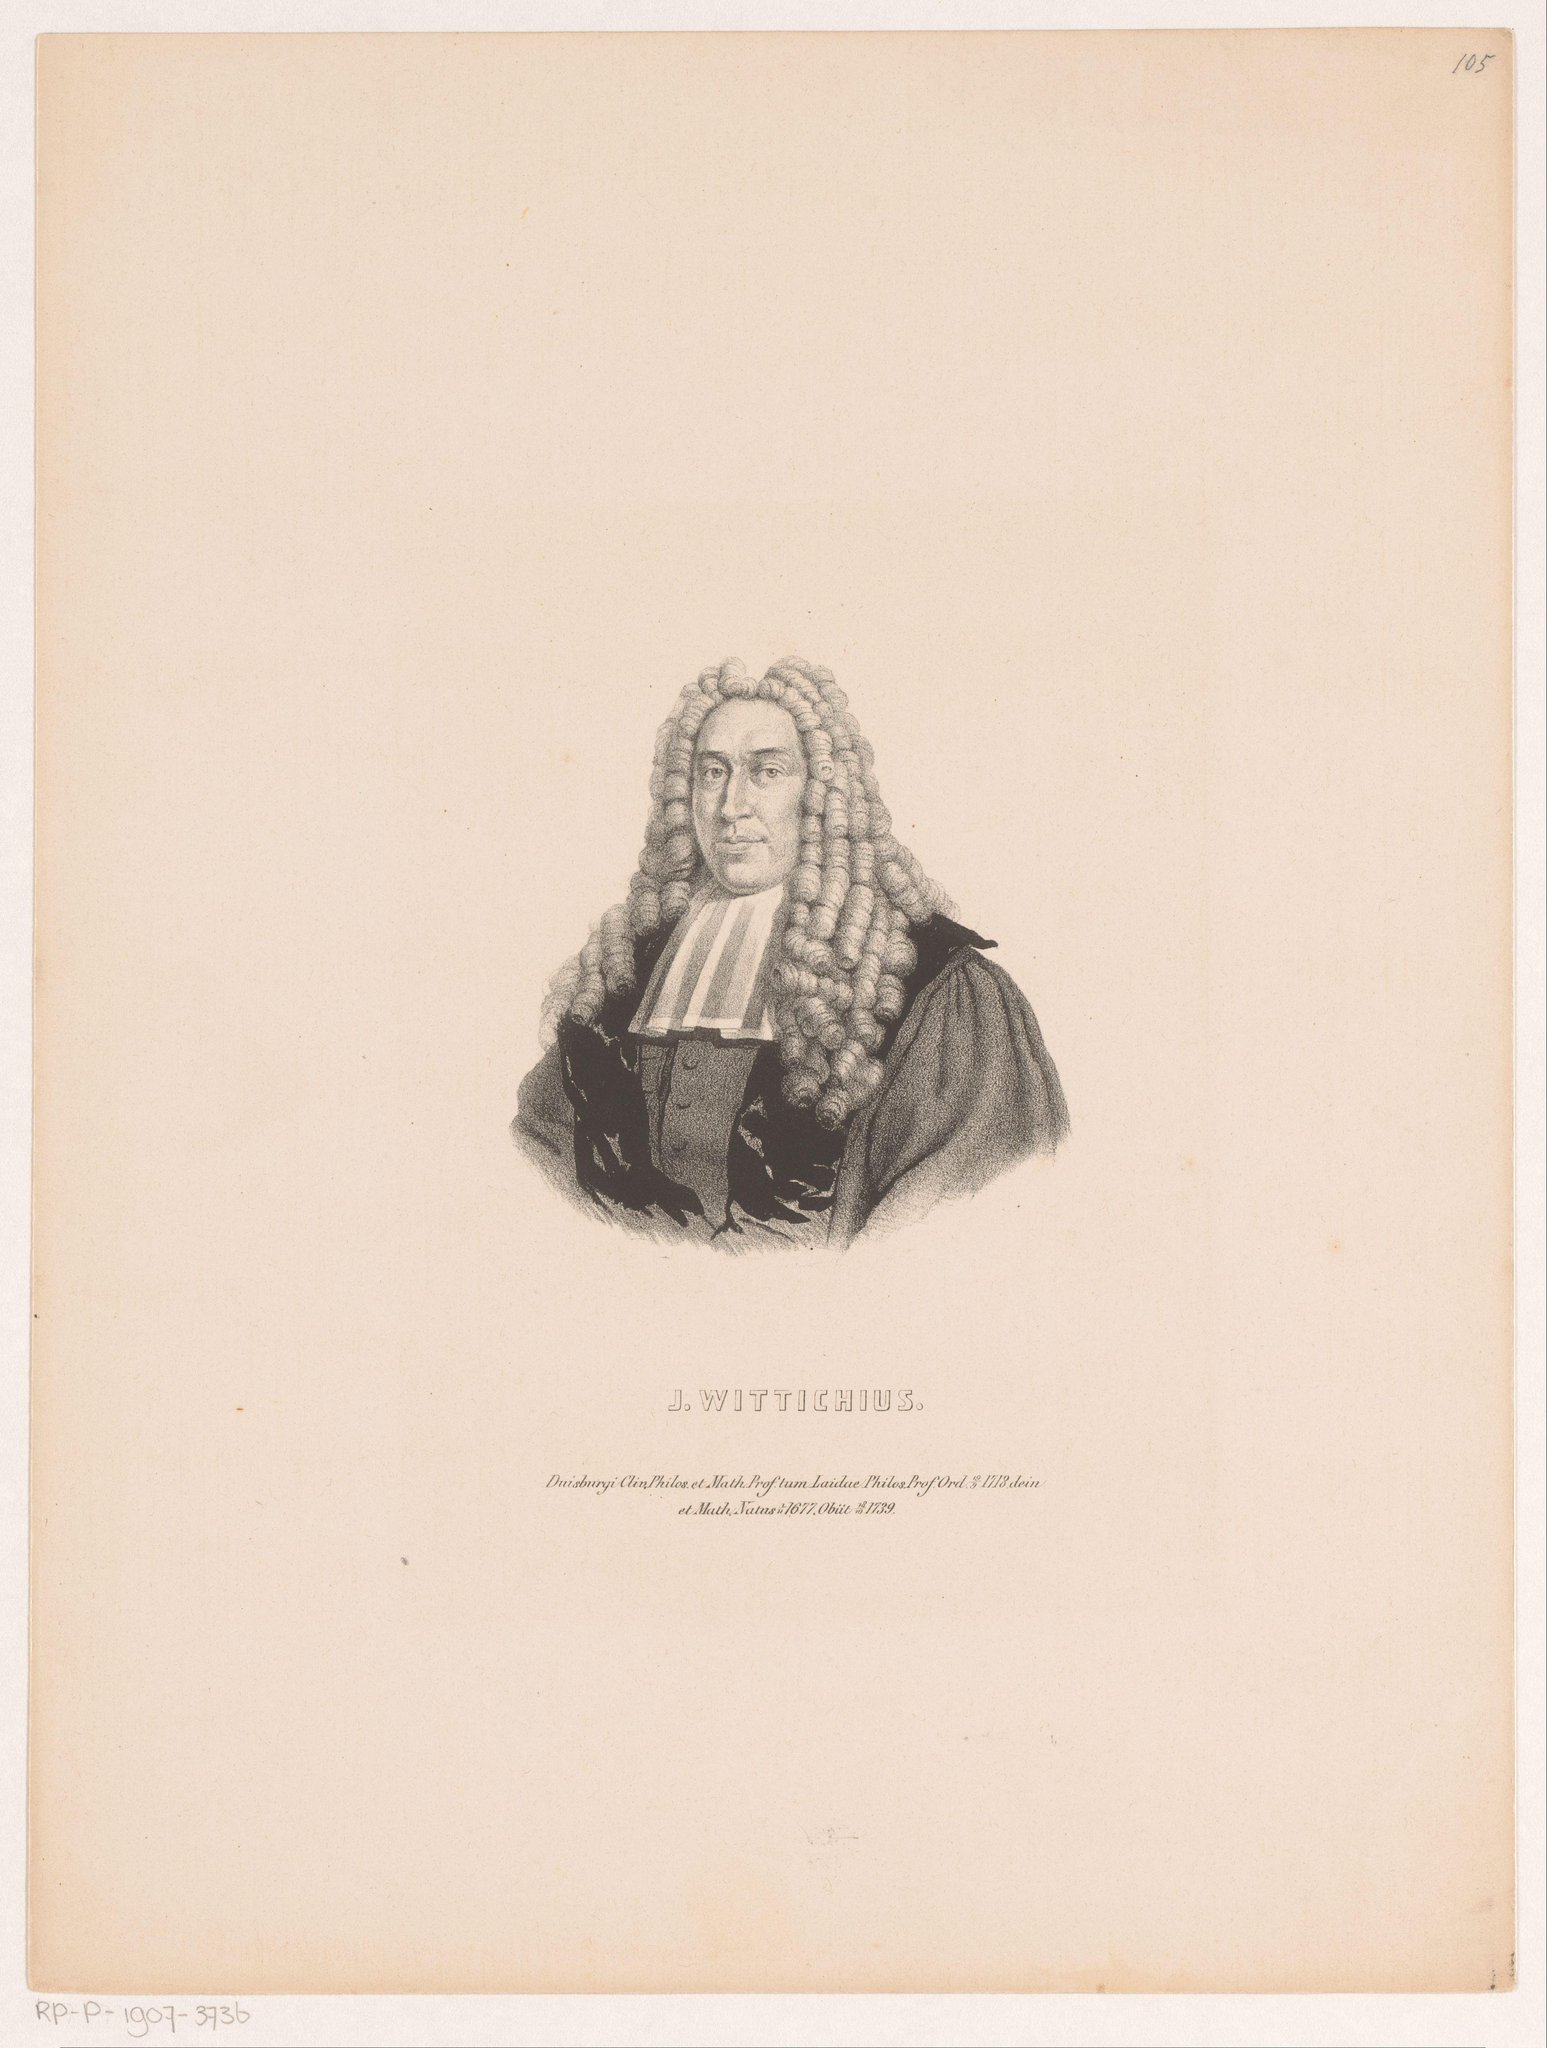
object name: print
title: J. Wittichius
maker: leendert springer (i)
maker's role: draughtsman, painter, print maker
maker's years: 1789-1871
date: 1850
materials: paper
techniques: lithograph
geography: leiden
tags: historical persons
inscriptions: collector's mark: Lugt 2228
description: Prent uit: Springer, Leendert. Galerij van hoogleeraren aan de Hoogeschool te Leijden, naar de oorspronkelijke afbeeldsels op de Senaat-zaal aldaar berustende. Leiden: Springer, Leendert., s.a. [circa 1850].